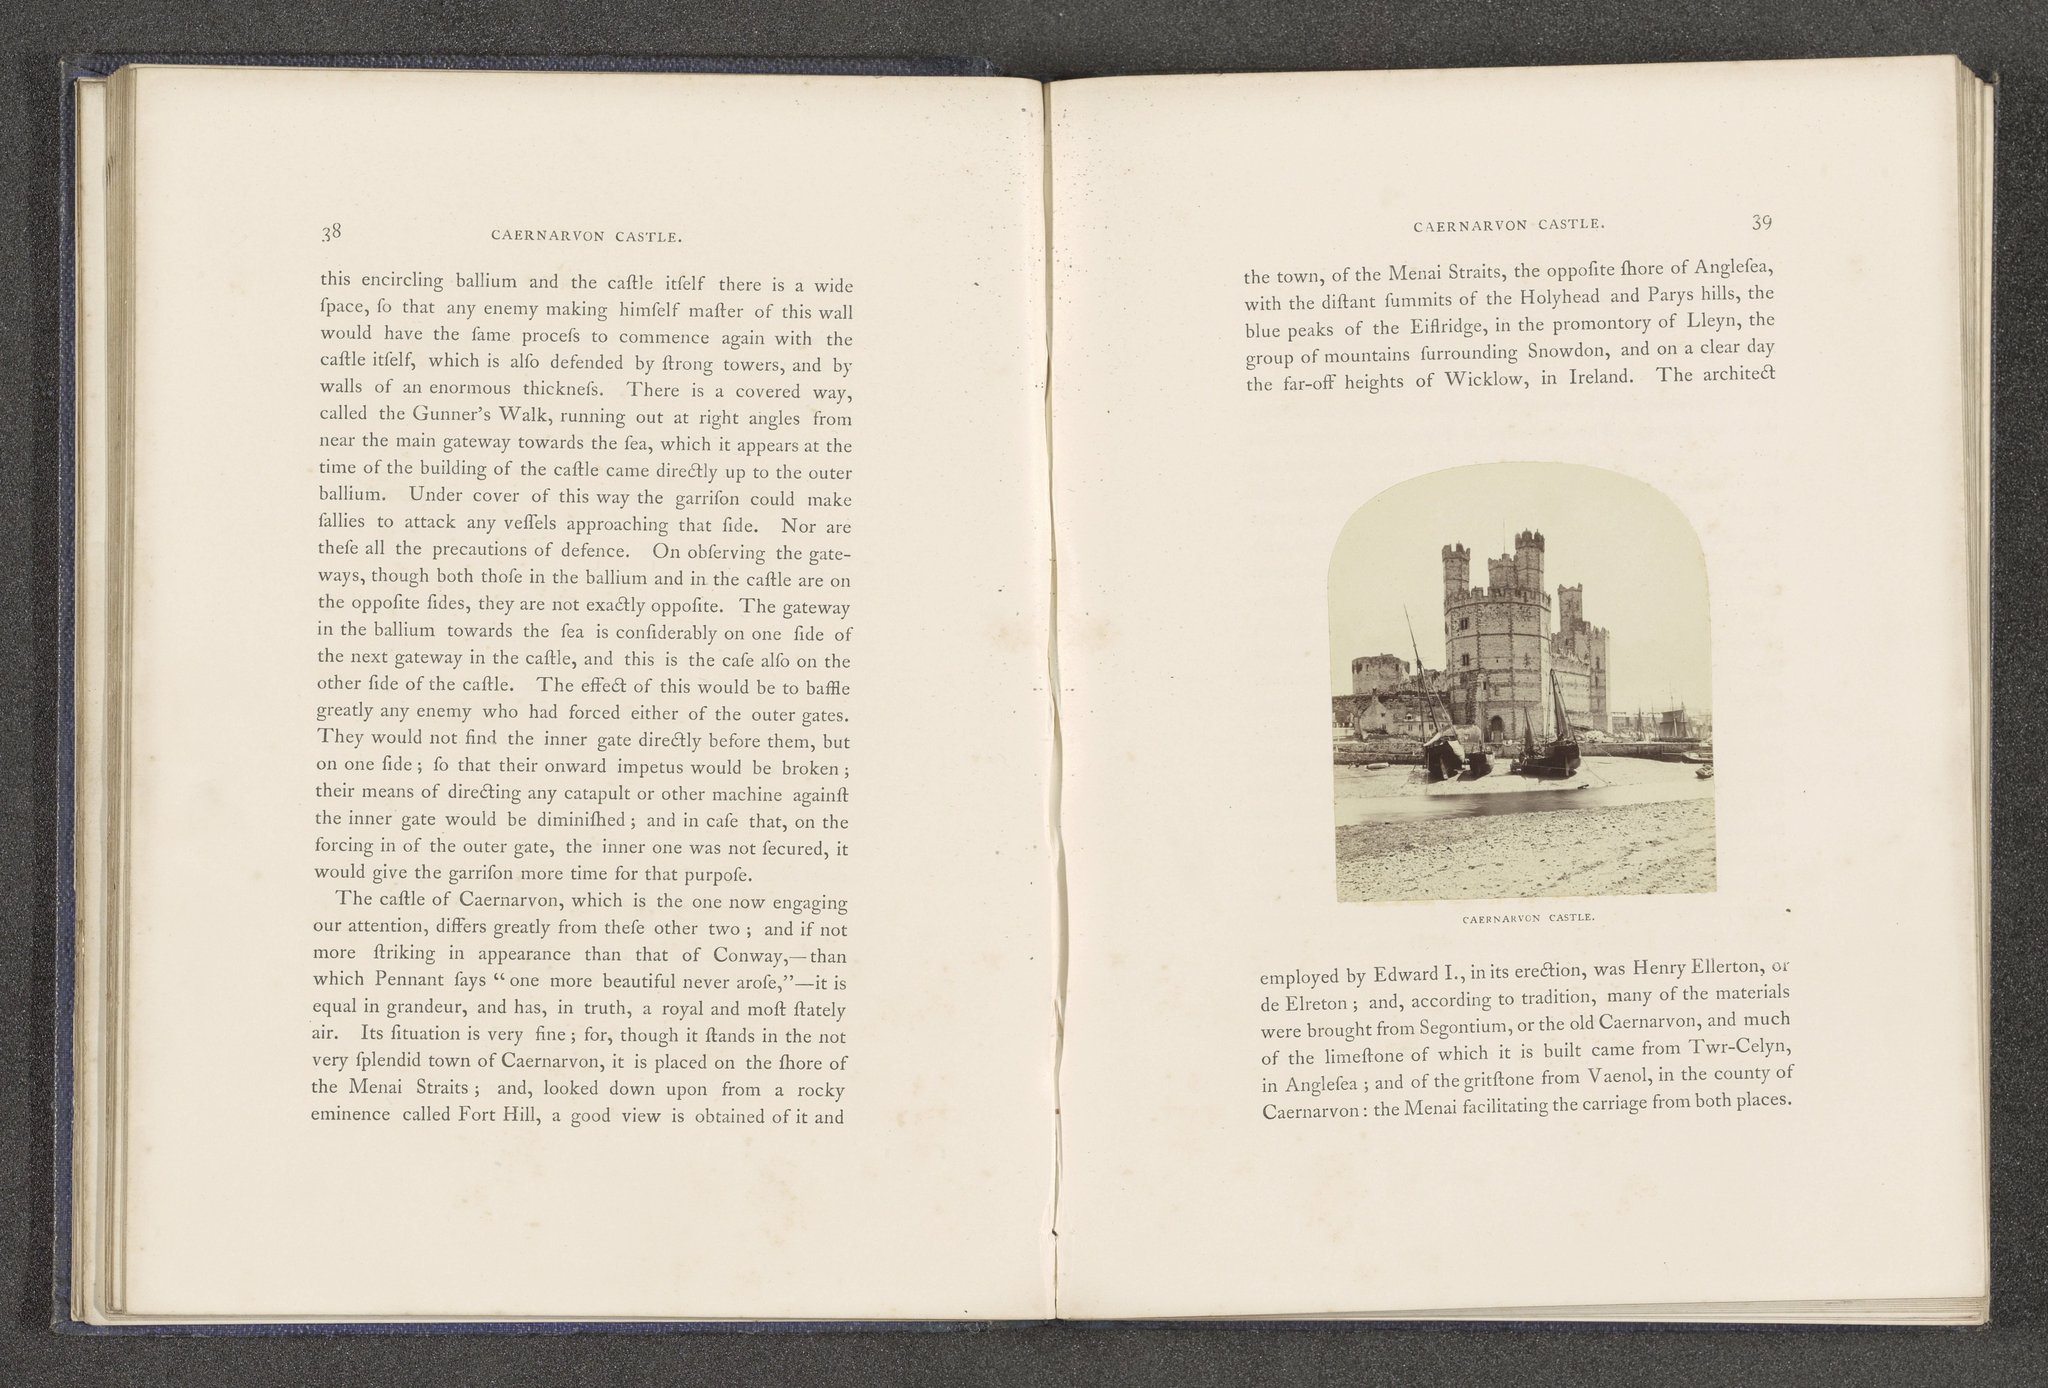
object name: page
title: Gezicht op Caernarfon Castle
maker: william russell sedgfield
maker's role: fotograaf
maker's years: 1826-1902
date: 1854-1864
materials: photographic support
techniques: albumen print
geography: caernarfon castle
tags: ruin of a dwelling, house, castle, etc.